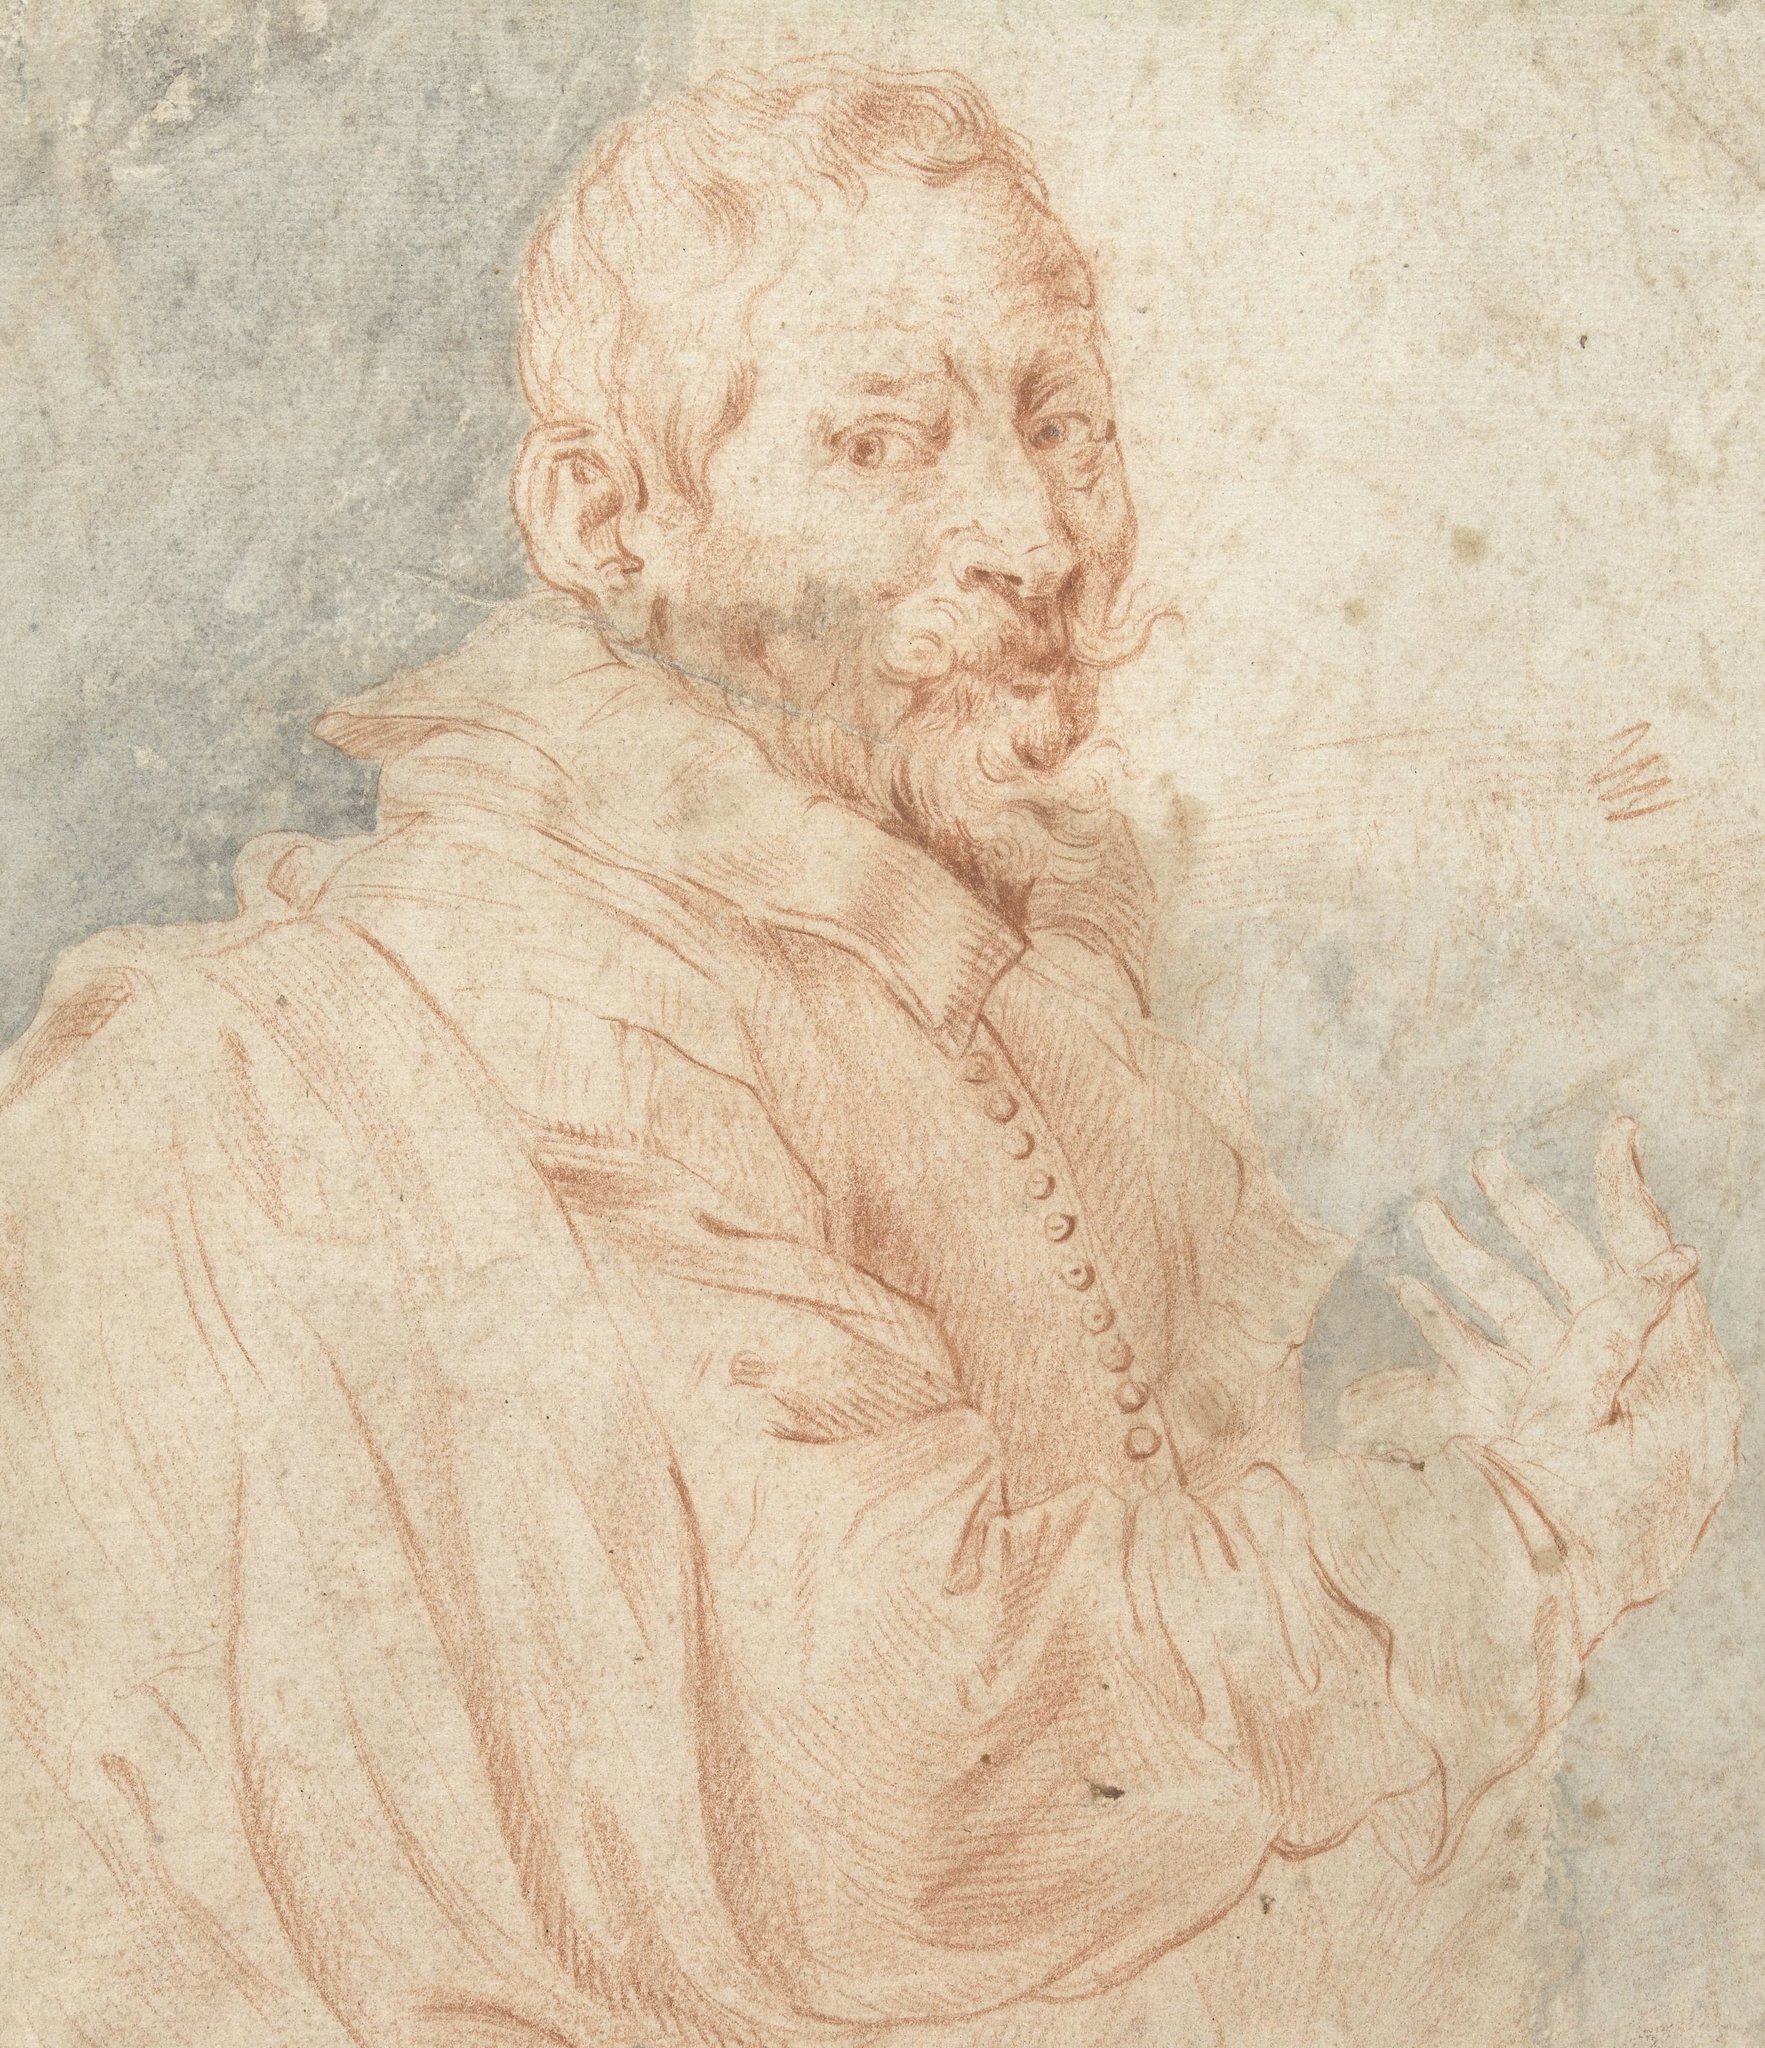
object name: drawing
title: Portret van Jodocus de Momper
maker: Anonymous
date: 1627-1691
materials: chalk, paper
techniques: brush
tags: antwerp, painter, draughtsman, joos de momper (ii), historical persons, portrait, self-portrait of painter